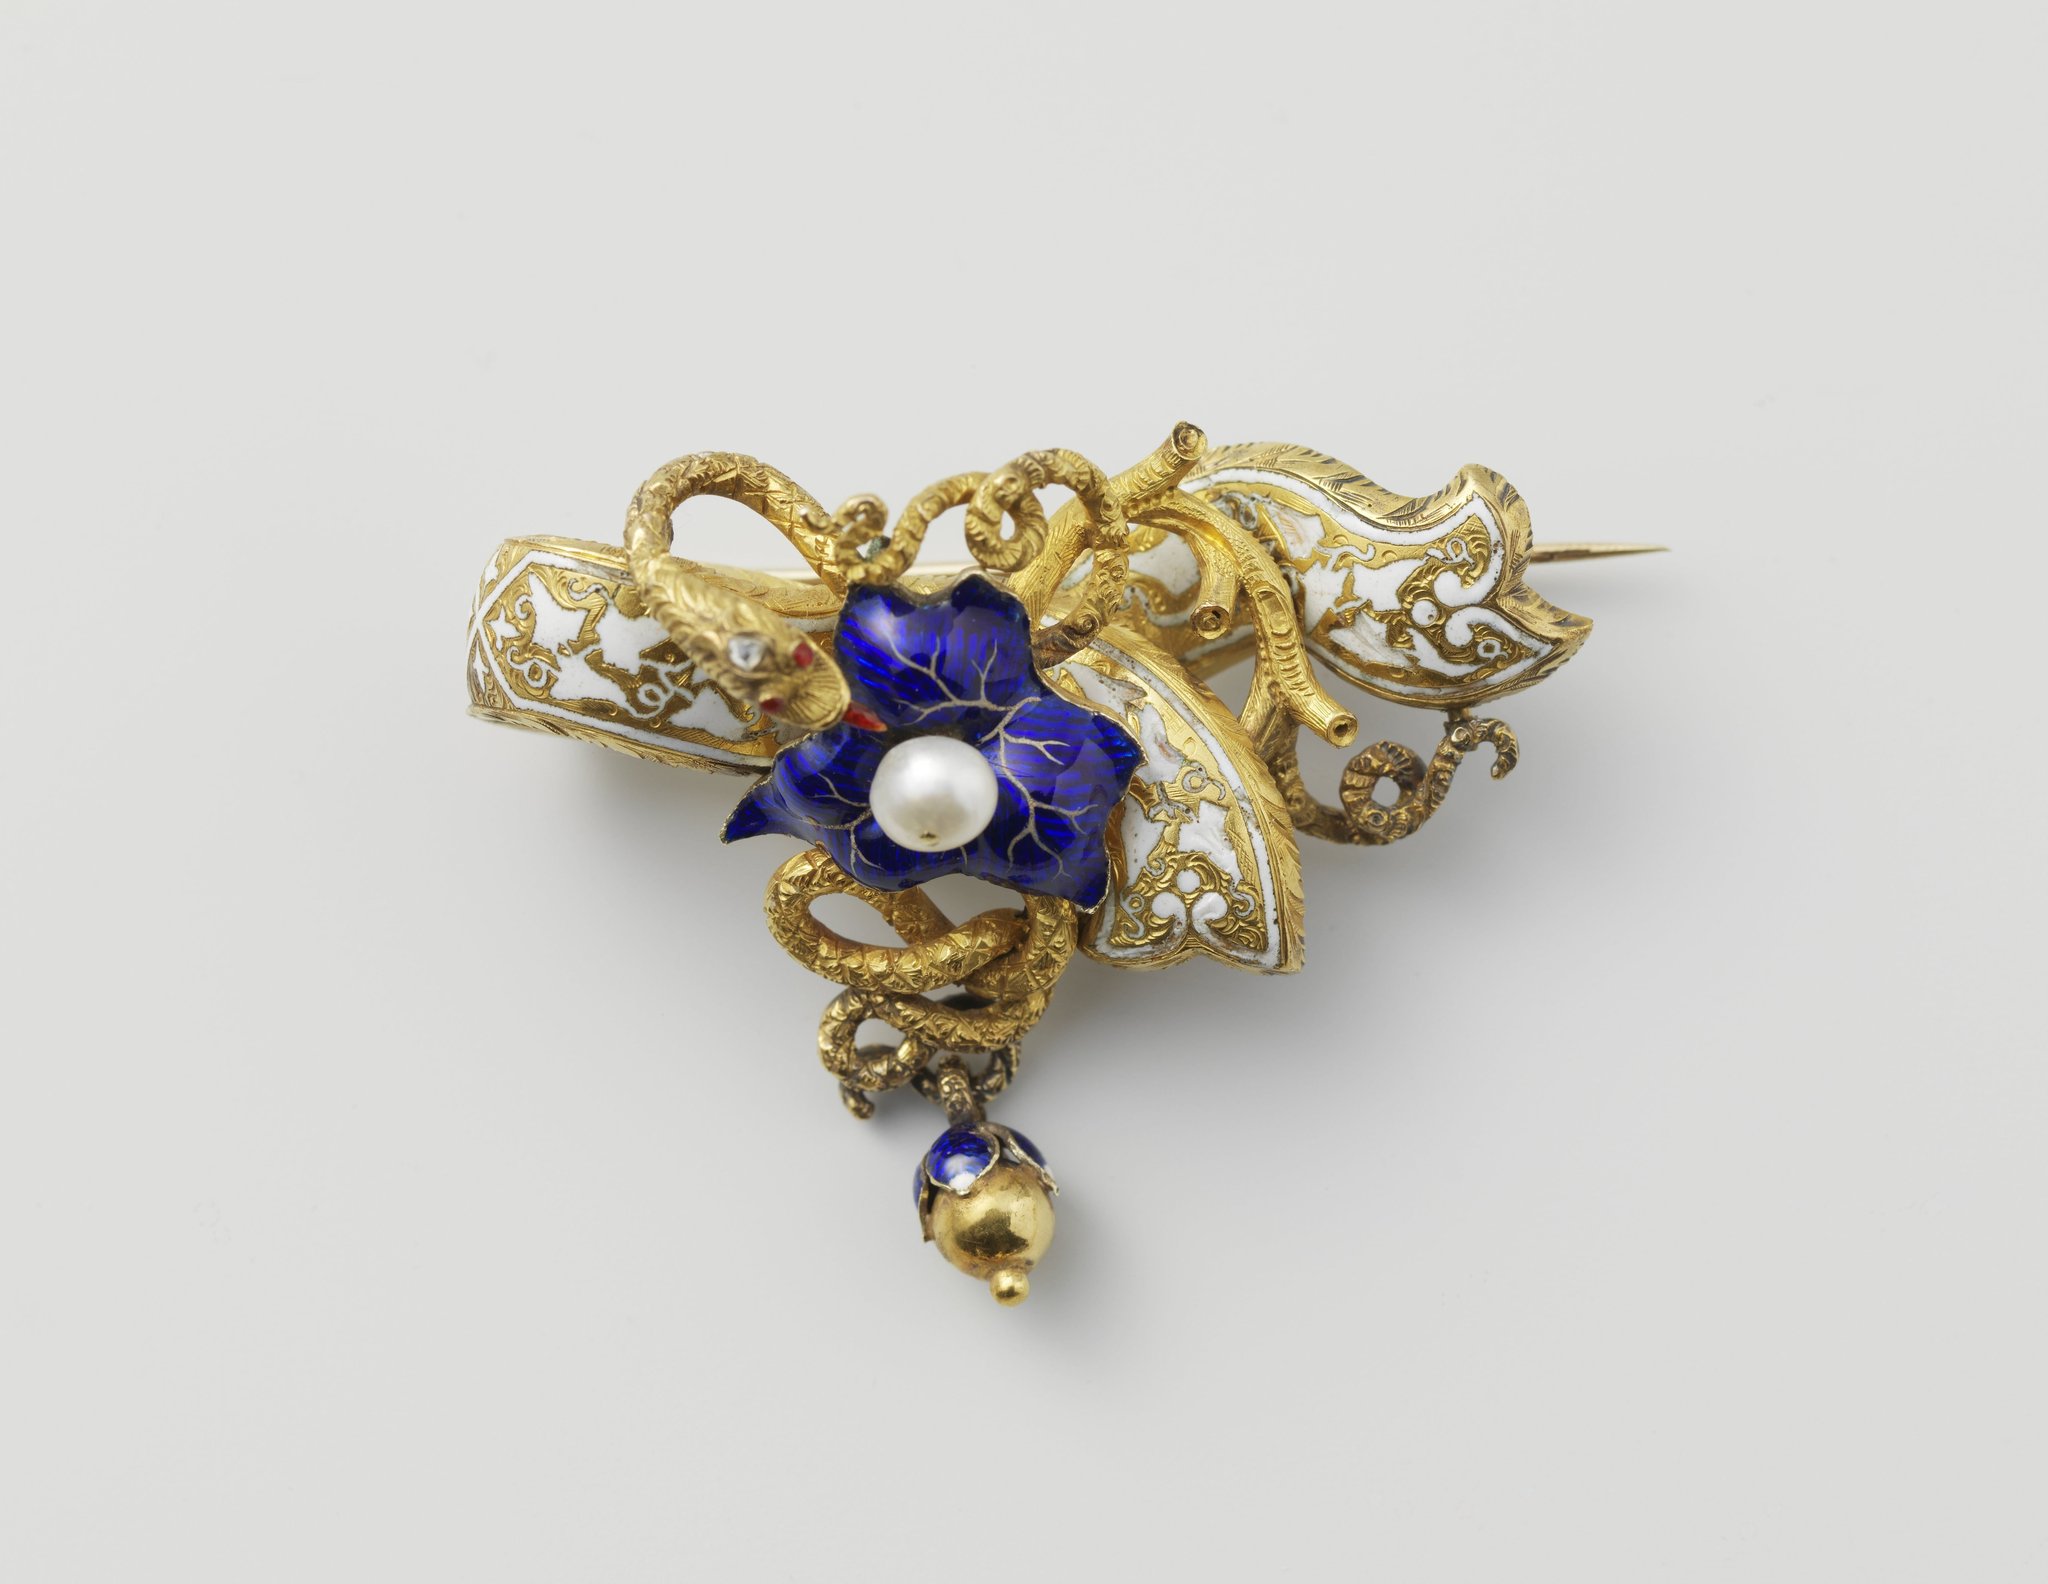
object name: brooch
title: Broche, deel van een demi-parure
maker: Anonymous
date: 1840-1849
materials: diamond, gold, pearl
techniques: enameling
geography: germany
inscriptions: mark: ‘IL (?) in rechthoek’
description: Parure. Gold, diamonds, pearls and enamel. Germany (?), c. 1840 - 1850.